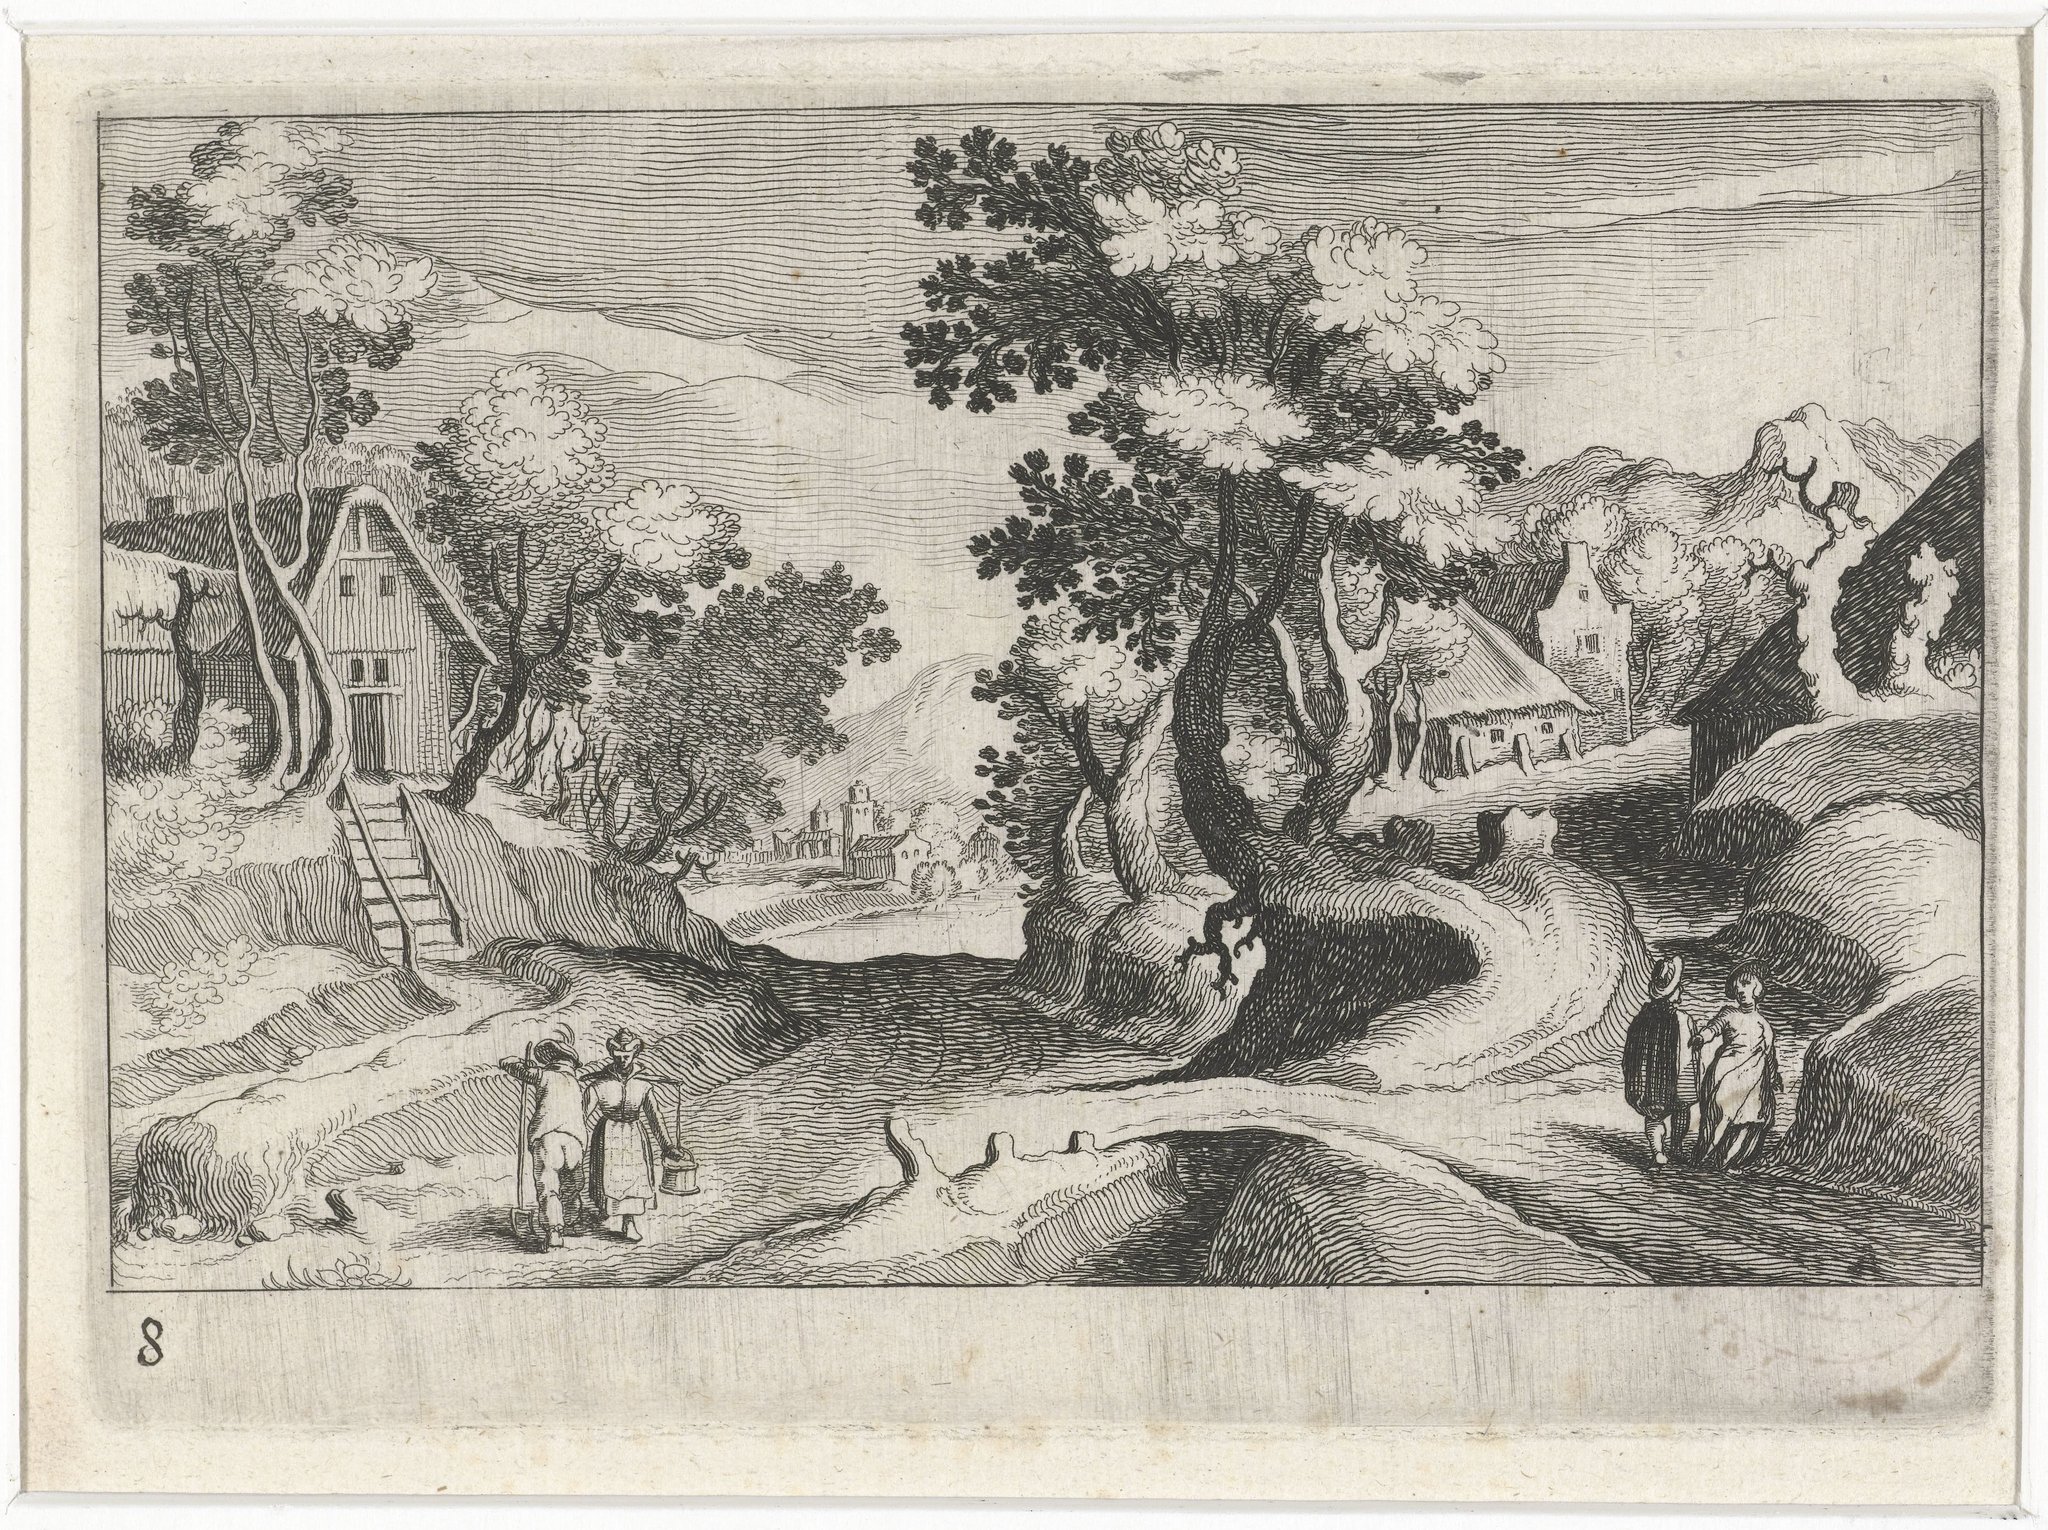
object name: print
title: Topographia variarum regionum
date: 1611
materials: paper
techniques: etching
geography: the hague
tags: city-view, and landscape with man-made constructions (+ city(-scape) with figures, staffage)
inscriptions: collector's mark: Lugt 240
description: Links op de voorgrond leunt een man op een hooivork naast een melkmeid. Rechts nog twee mensen op een pad.